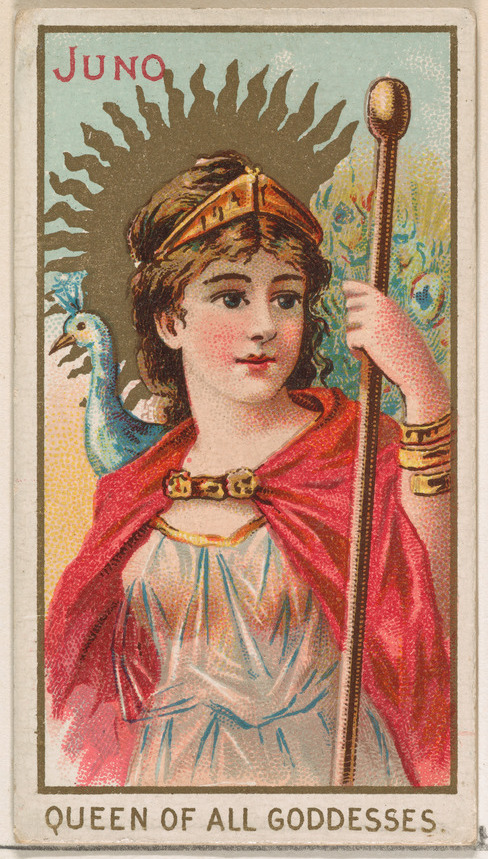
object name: print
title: Juno, Queen of all Goddesses, from the Goddesses of the Greeks and Romans series (N188) issued by Wm. S. Kimball & Co.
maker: william s. kimball & company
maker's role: publisher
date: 1889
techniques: color lithograph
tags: juno